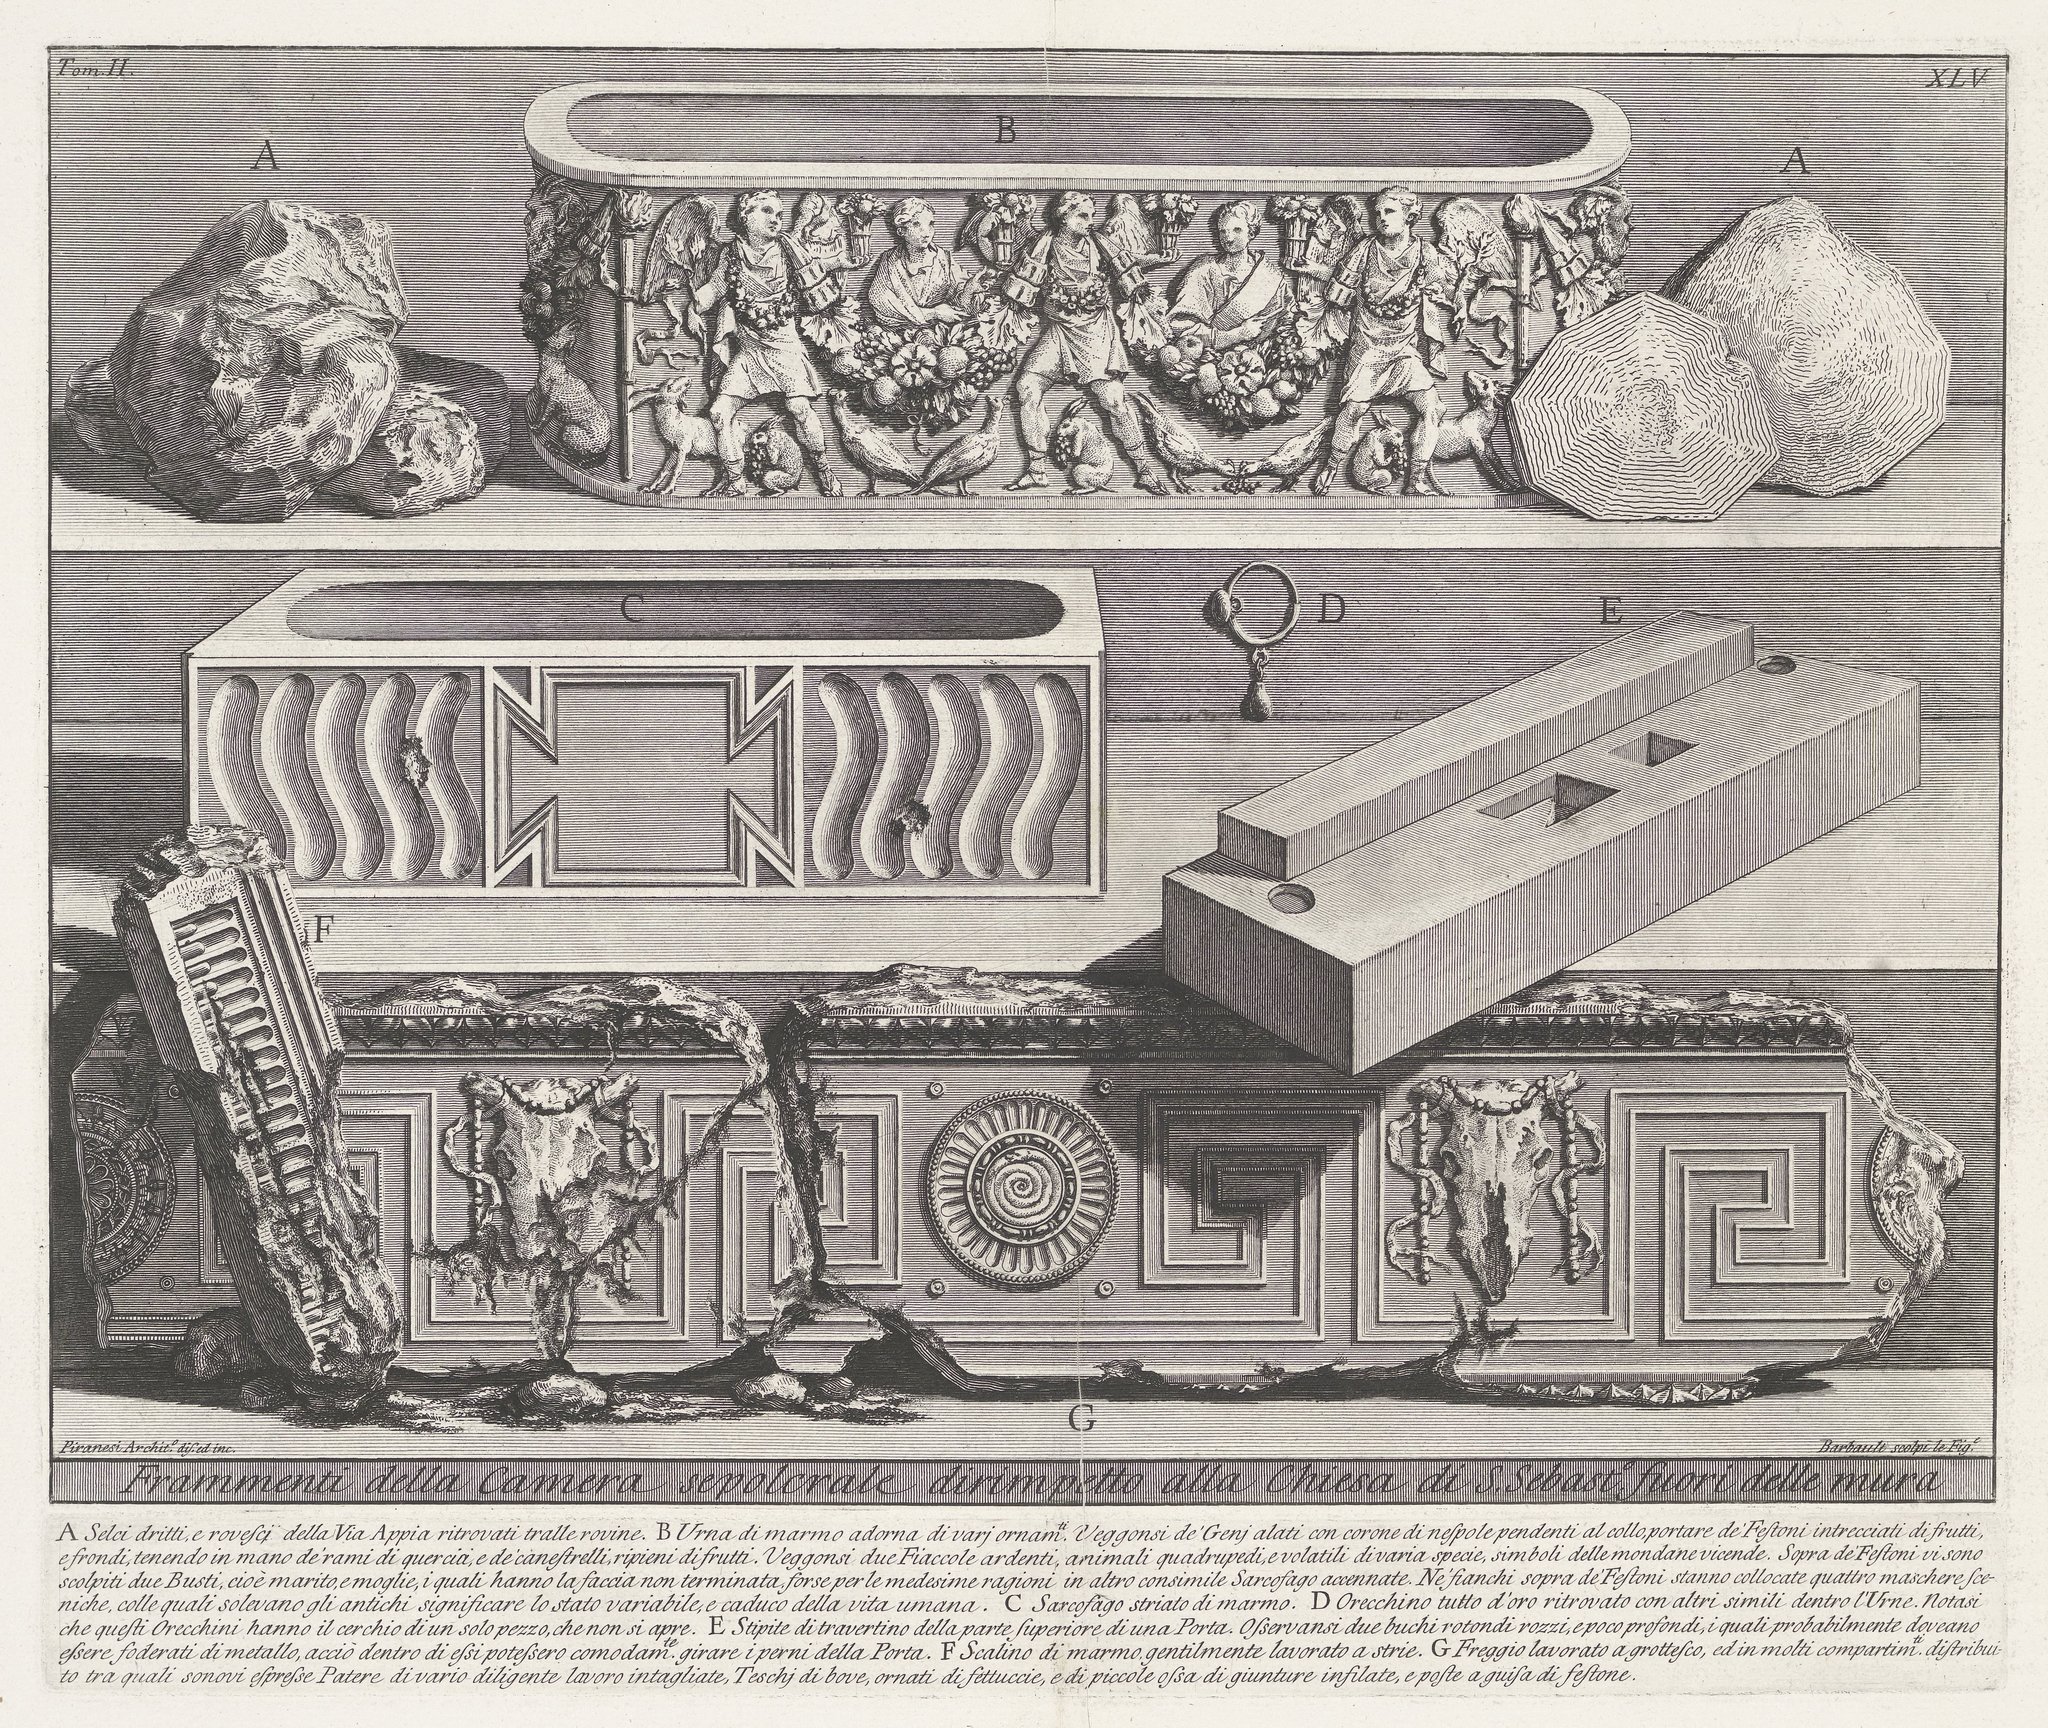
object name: print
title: Le Antichità Romane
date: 1756-1757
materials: paper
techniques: etching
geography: italy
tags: sarcophagus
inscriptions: collector's mark: Lugt 2228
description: Deze prent maakt deel uit van de serie 'Le Antichità Romane'. Piranesi deed meer dan acht jaar voorstudie voor deze 250 platen tellende serie die in vier volumes werd uitgegeven. Hij produceerde de prenten tussen ca. 1756 en 1757. De serie bevat ook prenten door of naar andere prentmakers, onder wie Francesco Bianchini en Girolamo Rossi.